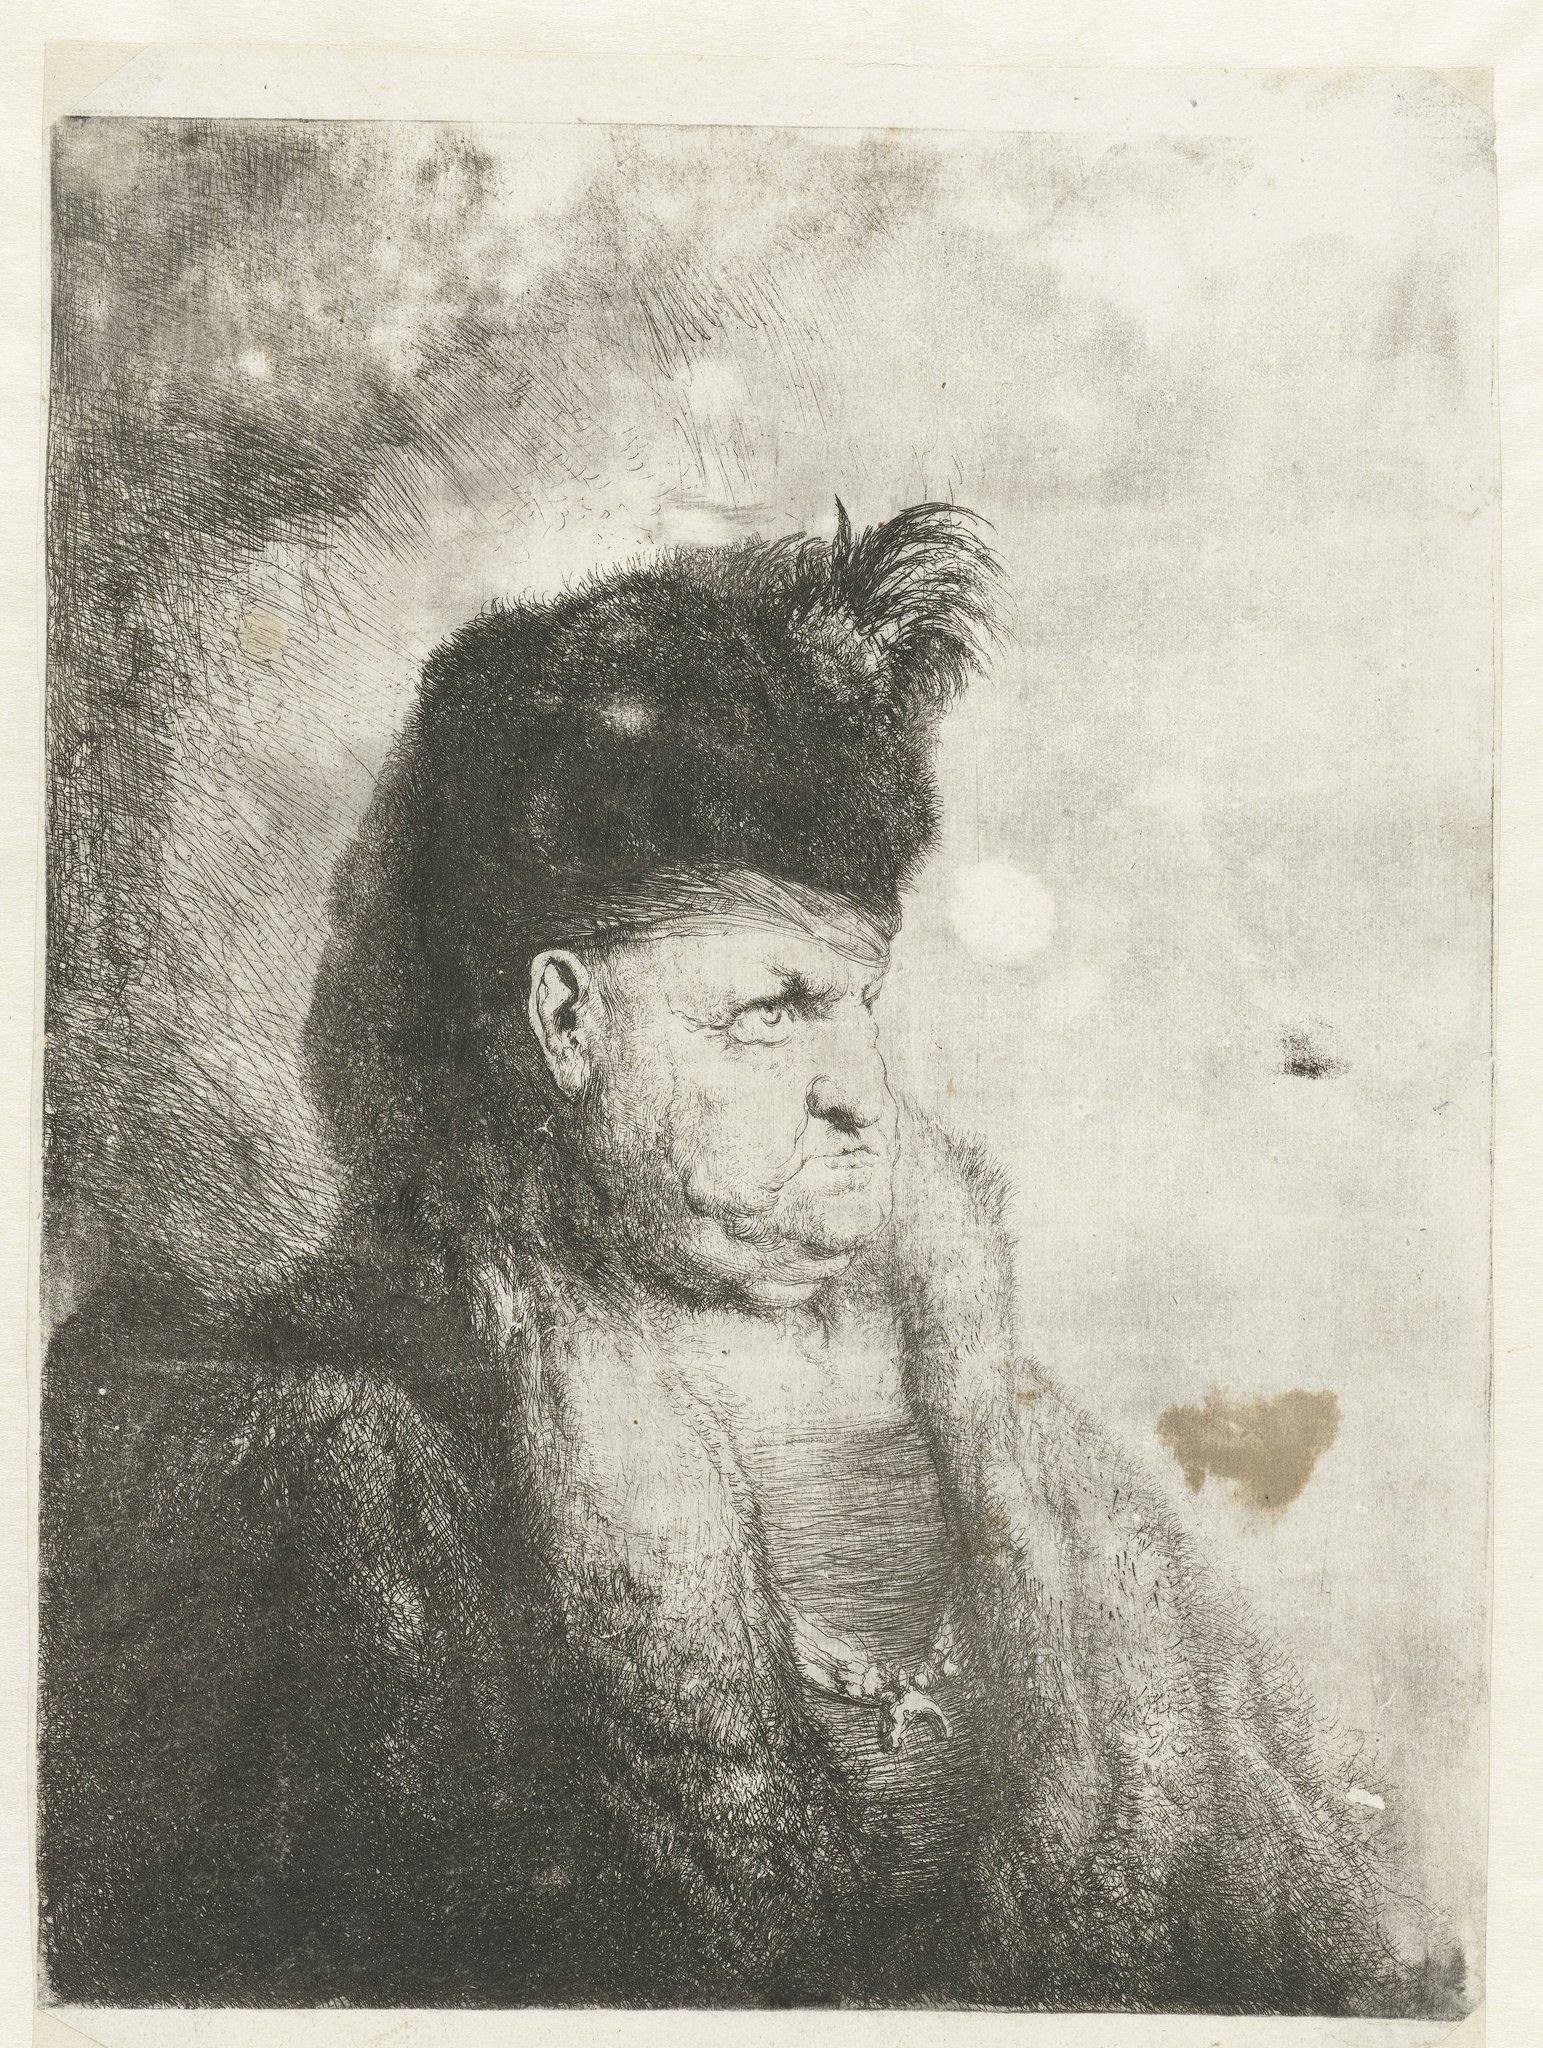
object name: print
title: Borstbeeld van een oosterling met bontmuts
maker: jan lievens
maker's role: draughtsman, painter, print maker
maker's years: 1607-1674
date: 1625-1631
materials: paper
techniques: etching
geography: leiden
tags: human races; peoples; nationalities (+ costume), fashion, clothing (+ fur used for clothes), male sex; man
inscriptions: collector's mark: Lugt 240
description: Bij Hollstein wordt een staat niet vermeld, er zijn vier staten van deze prent bekend (Schatborn 1988)